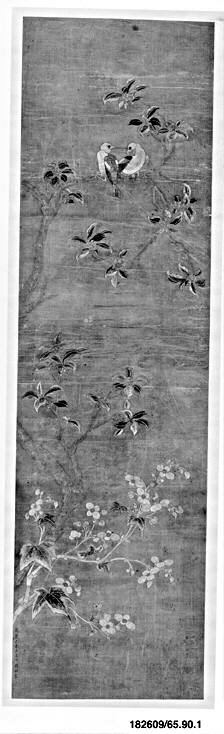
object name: panel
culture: chinese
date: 1573-1620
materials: paint, silk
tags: birds,flowers